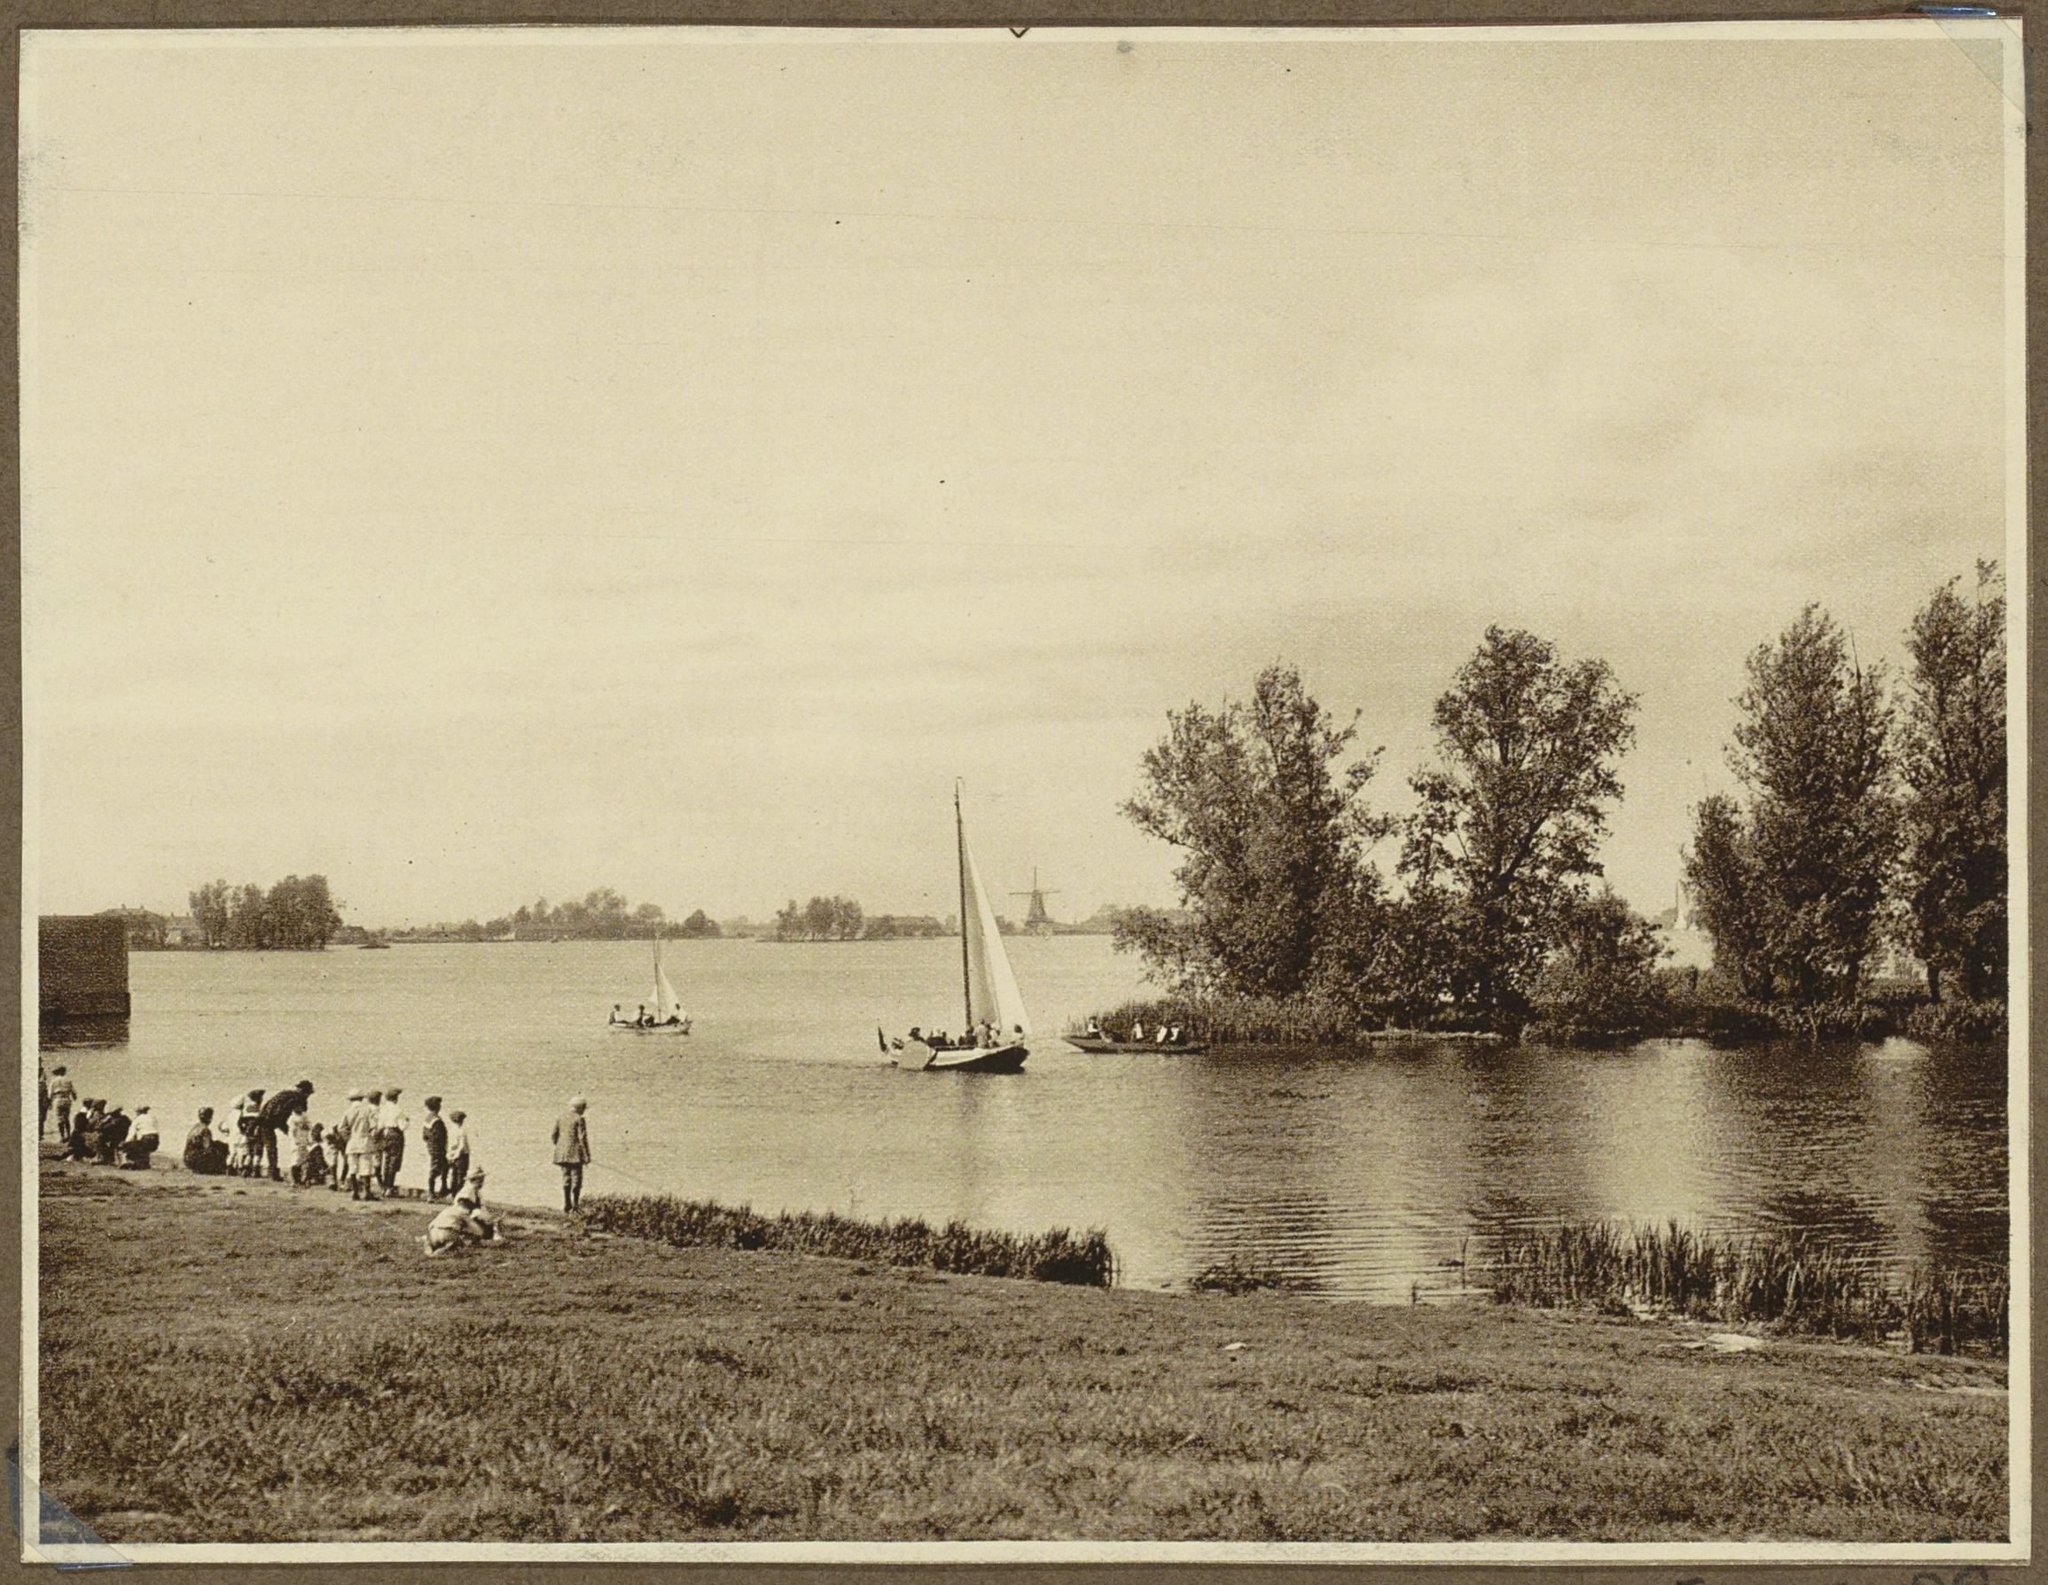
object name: photograph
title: Publiek kijkt vanaf de wal naar zeilschepen op een plas, mogelijk bij Amsterdam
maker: Anonymous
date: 1910-1930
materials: paper, photographic support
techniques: rotogravure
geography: amsterdam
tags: sailing-ship, sailing-boat, amsterdam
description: Onderdeel van Album met foto's van Amsterdam en omgeving.